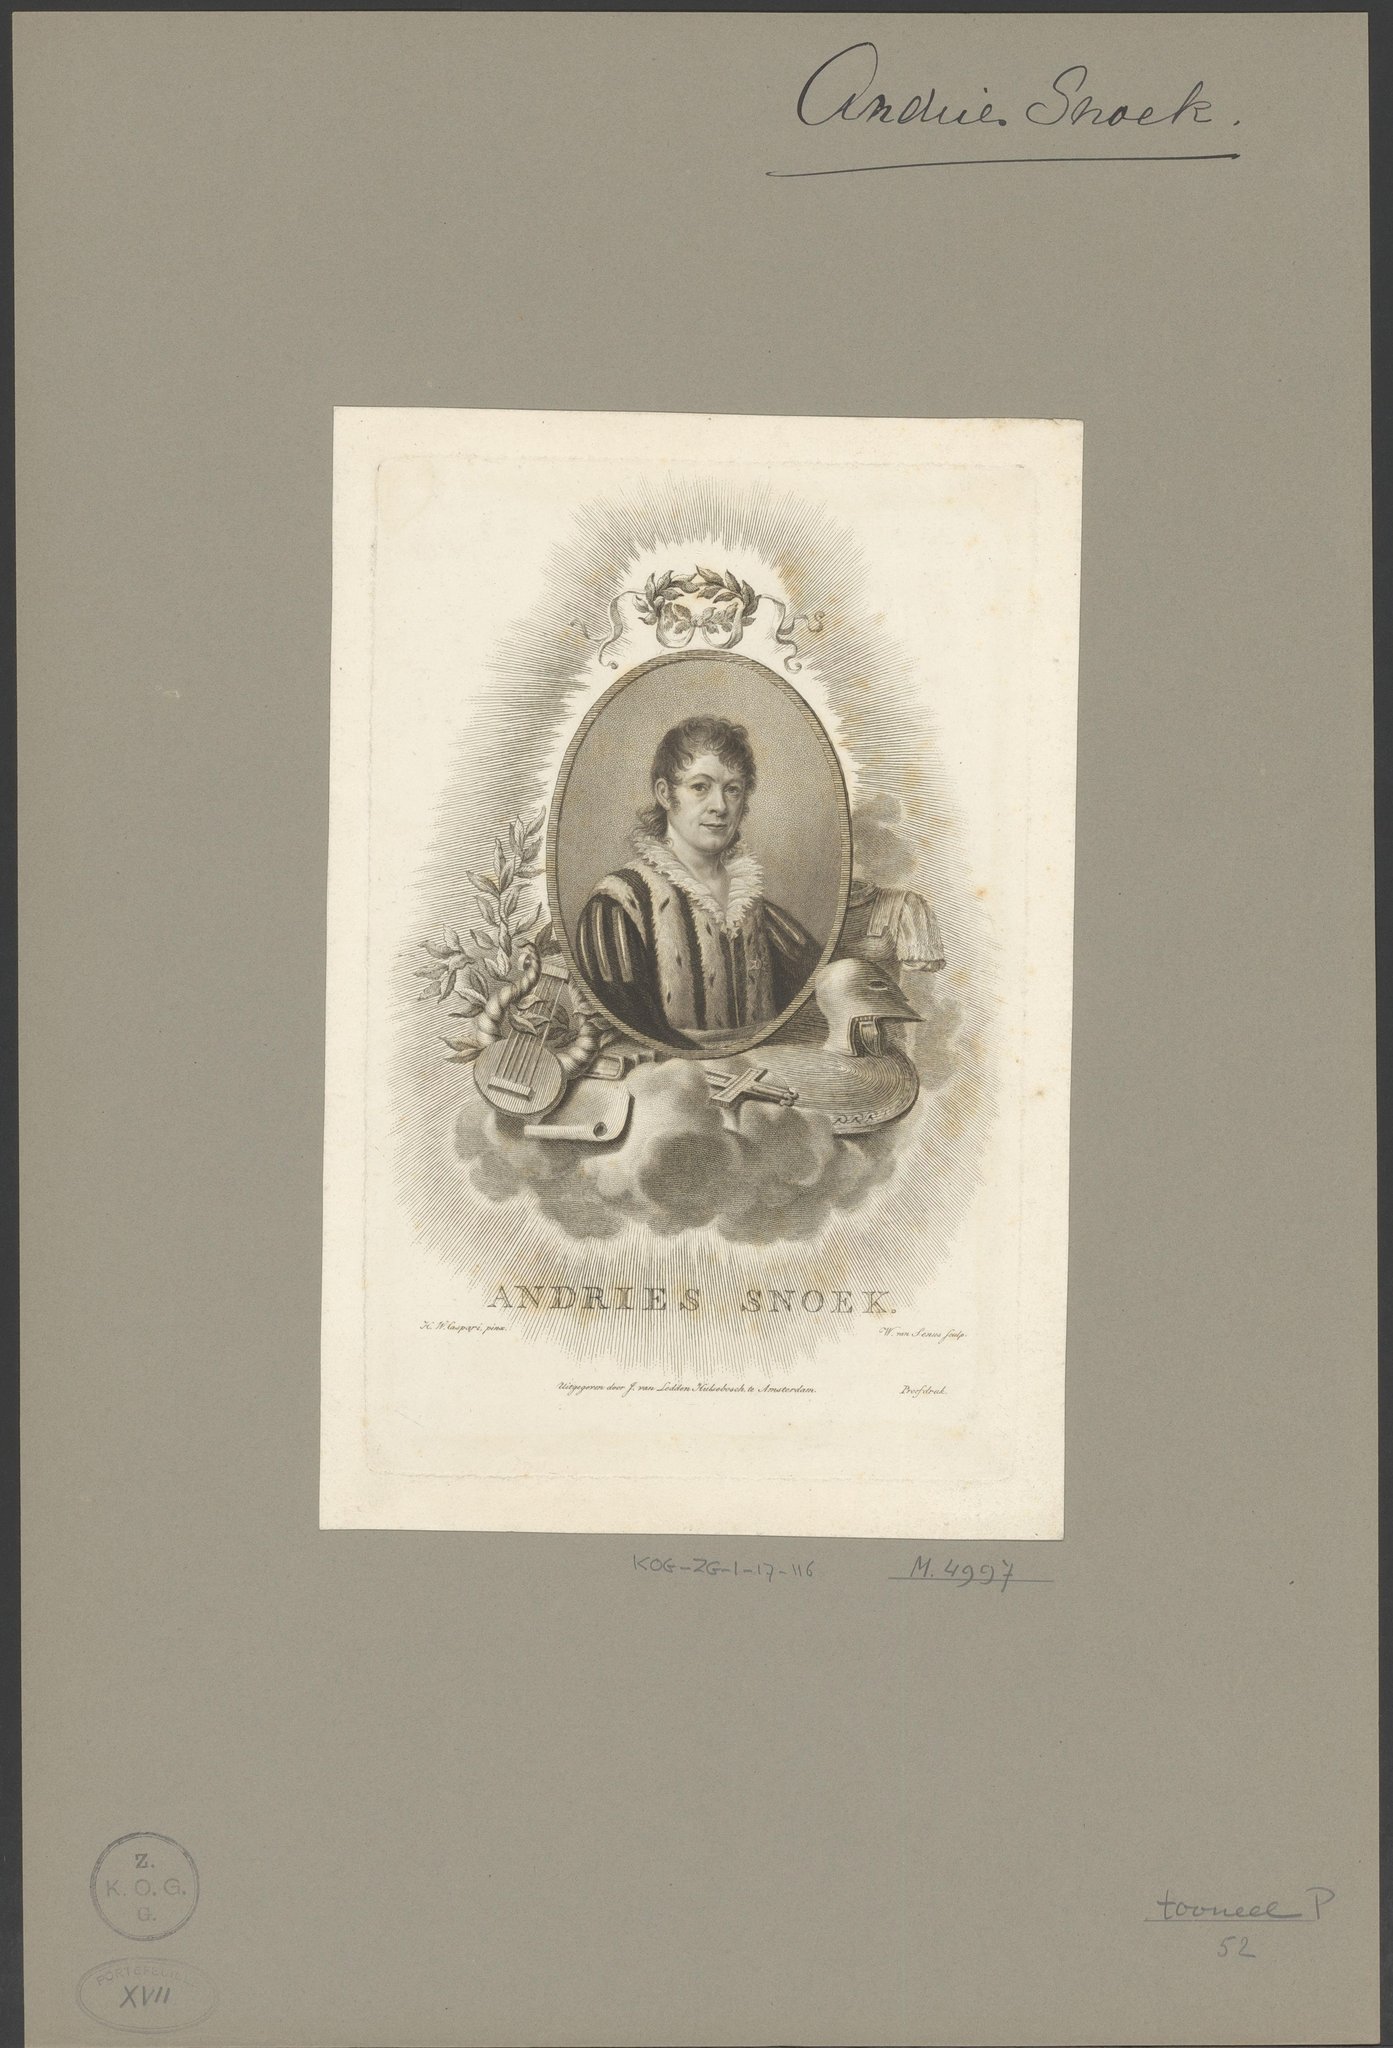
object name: print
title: Andries Snoek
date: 1787-1851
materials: paper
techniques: etching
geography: amsterdam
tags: rotterdam, amsterdam, mask, portrait of actor, actress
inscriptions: stamp, collector's mark: Lugt 1641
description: Onderwerpsrubrieken binnen de Atlas Zeden en Gewoonten: Tooneel, Portretten van toneelspelers.